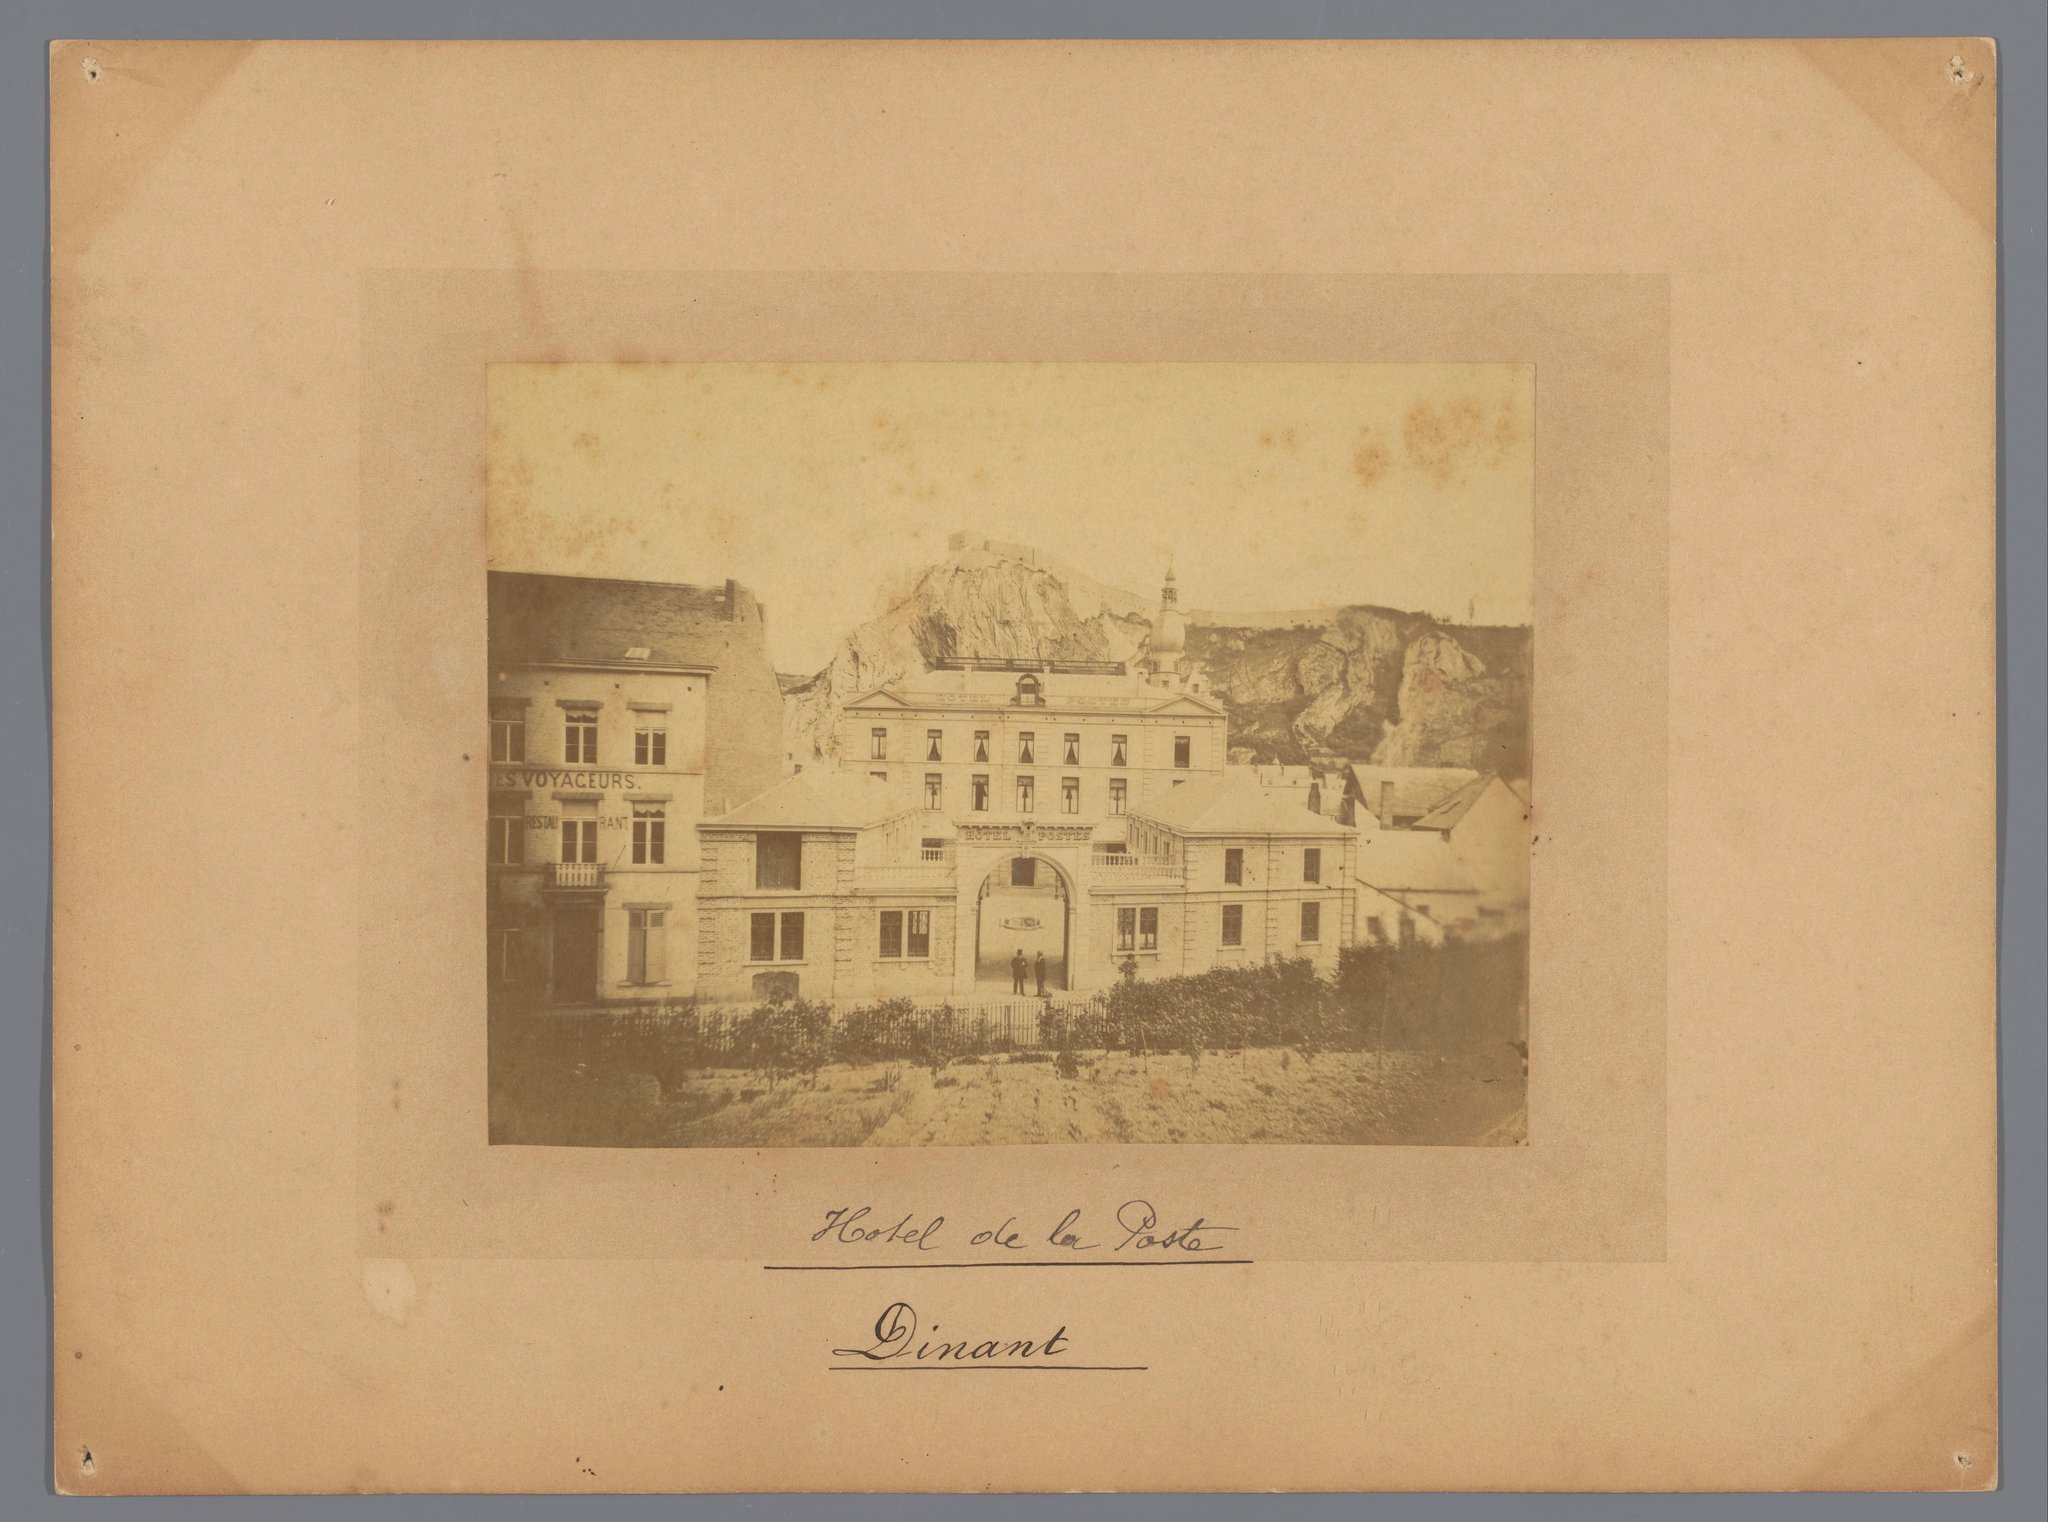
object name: photograph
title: Hotel de la Poste, Dinant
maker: Anonymous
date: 1860-1918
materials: cardboard, paper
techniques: albumen print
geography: dinant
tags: post-office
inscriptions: inscription: ‘Hotel des Poste Dinant’, number: ‘25’